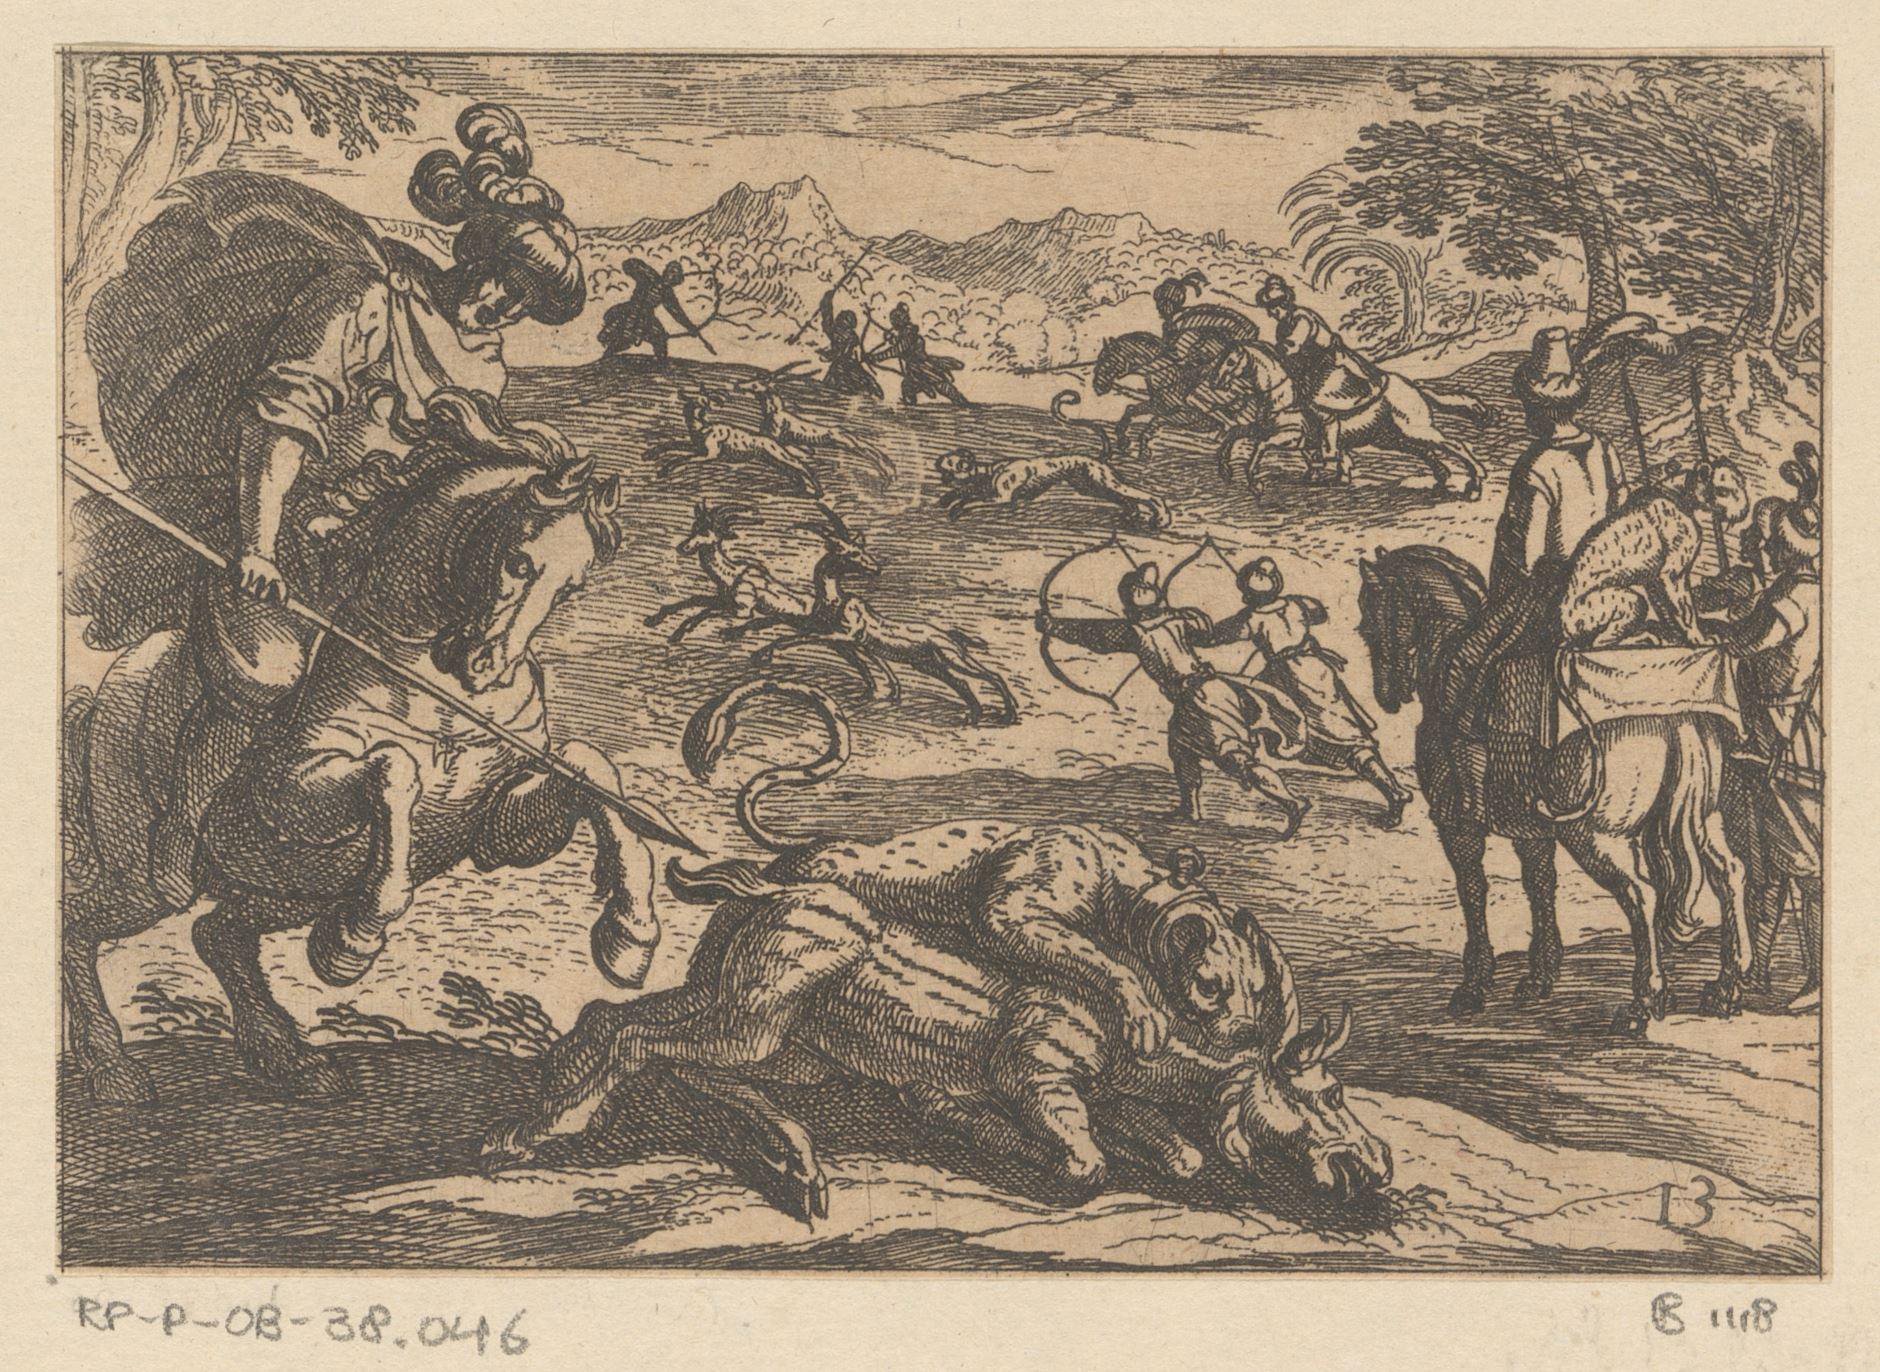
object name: print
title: Jachtscènes (deel 3)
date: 1598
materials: paper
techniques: etching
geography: rome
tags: beasts of prey, predatory animals: leopard, stag-hunting, hunter, hunters hunting (n.b.: in 1988-1990 this notation denoted the concept of 43c11421 'hunters resting during the hunt')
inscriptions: collector's mark: Lugt 240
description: Deze prent maakt deel uit van een reeks van vijftien prenten met jachtscènes (+ opdracht).